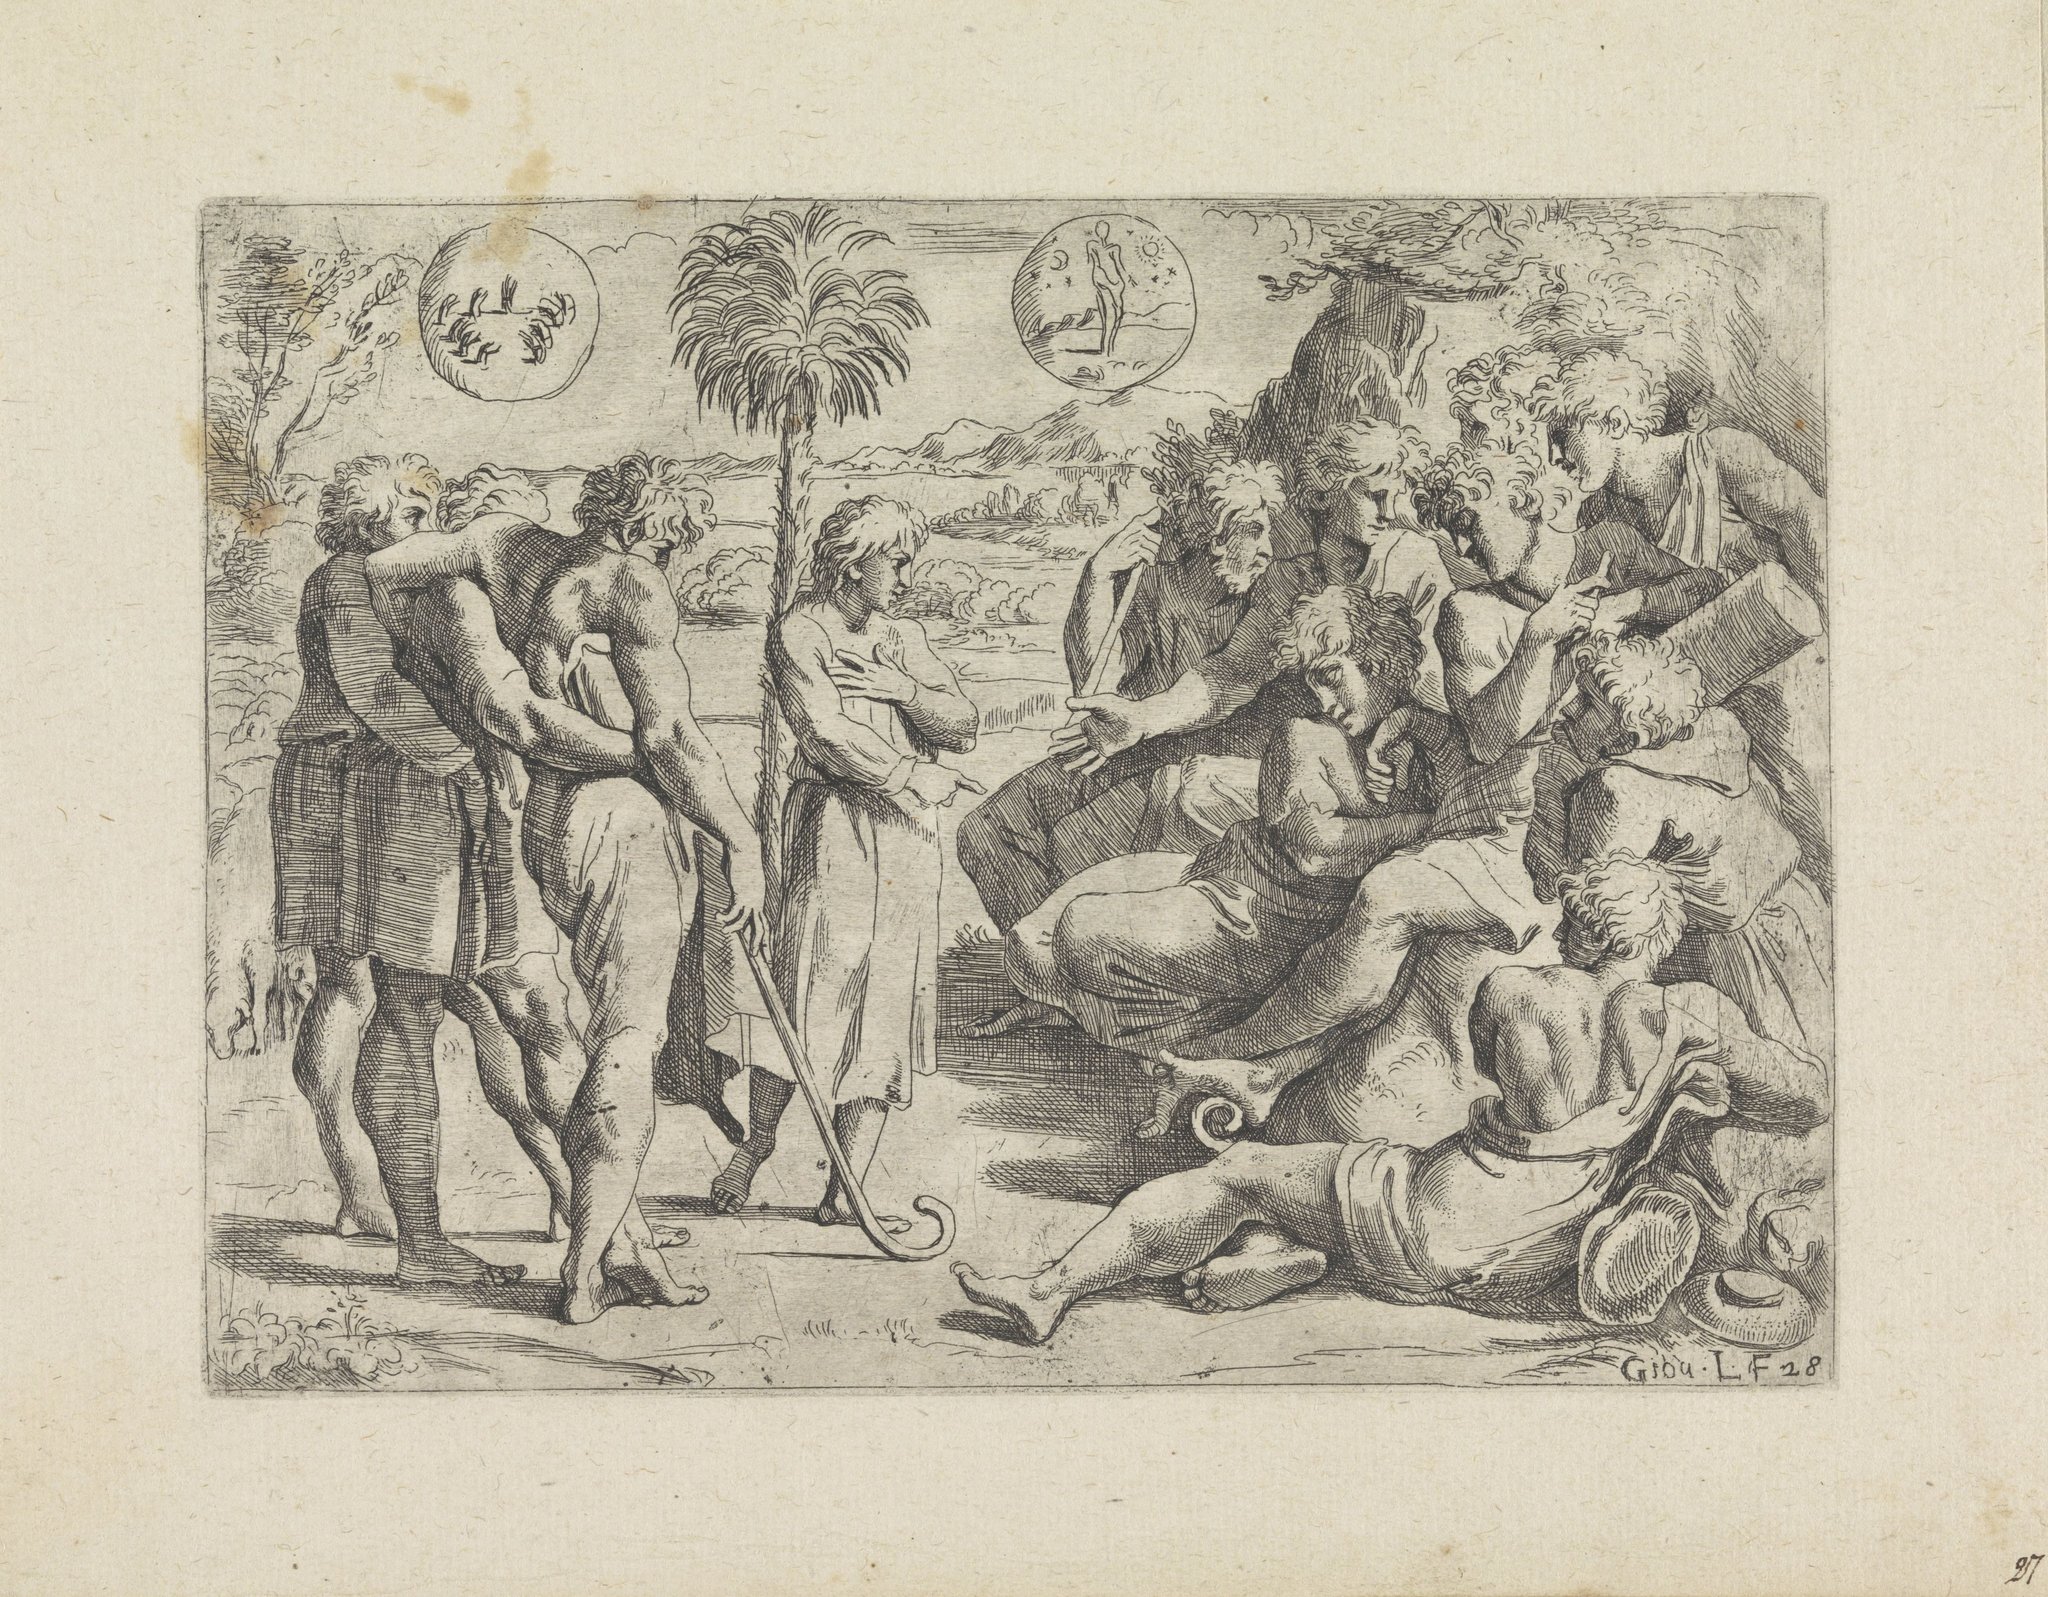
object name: print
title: Historia del Testamento Vecchio / Dipinta in Roma nel Vaticano da Raffaelle di Urbin (...)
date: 1607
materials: paper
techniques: etching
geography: italy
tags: story of joseph (part i), first dream of joseph: the eleven sheaves of wheat of his brothers form a circle round joseph's sheaf and bow down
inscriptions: number: ‘27’, collector's mark: Lugt 11, collector's mark: ‘Hinloopen’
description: Jozef legt zijn droom uit aan zijn broers. Hij vertelt dat in zijn droom de korenschoven van zijn broers bogen voor zijn eigen schoof en dat ook de zon, maan en sterren voor hem bogen.